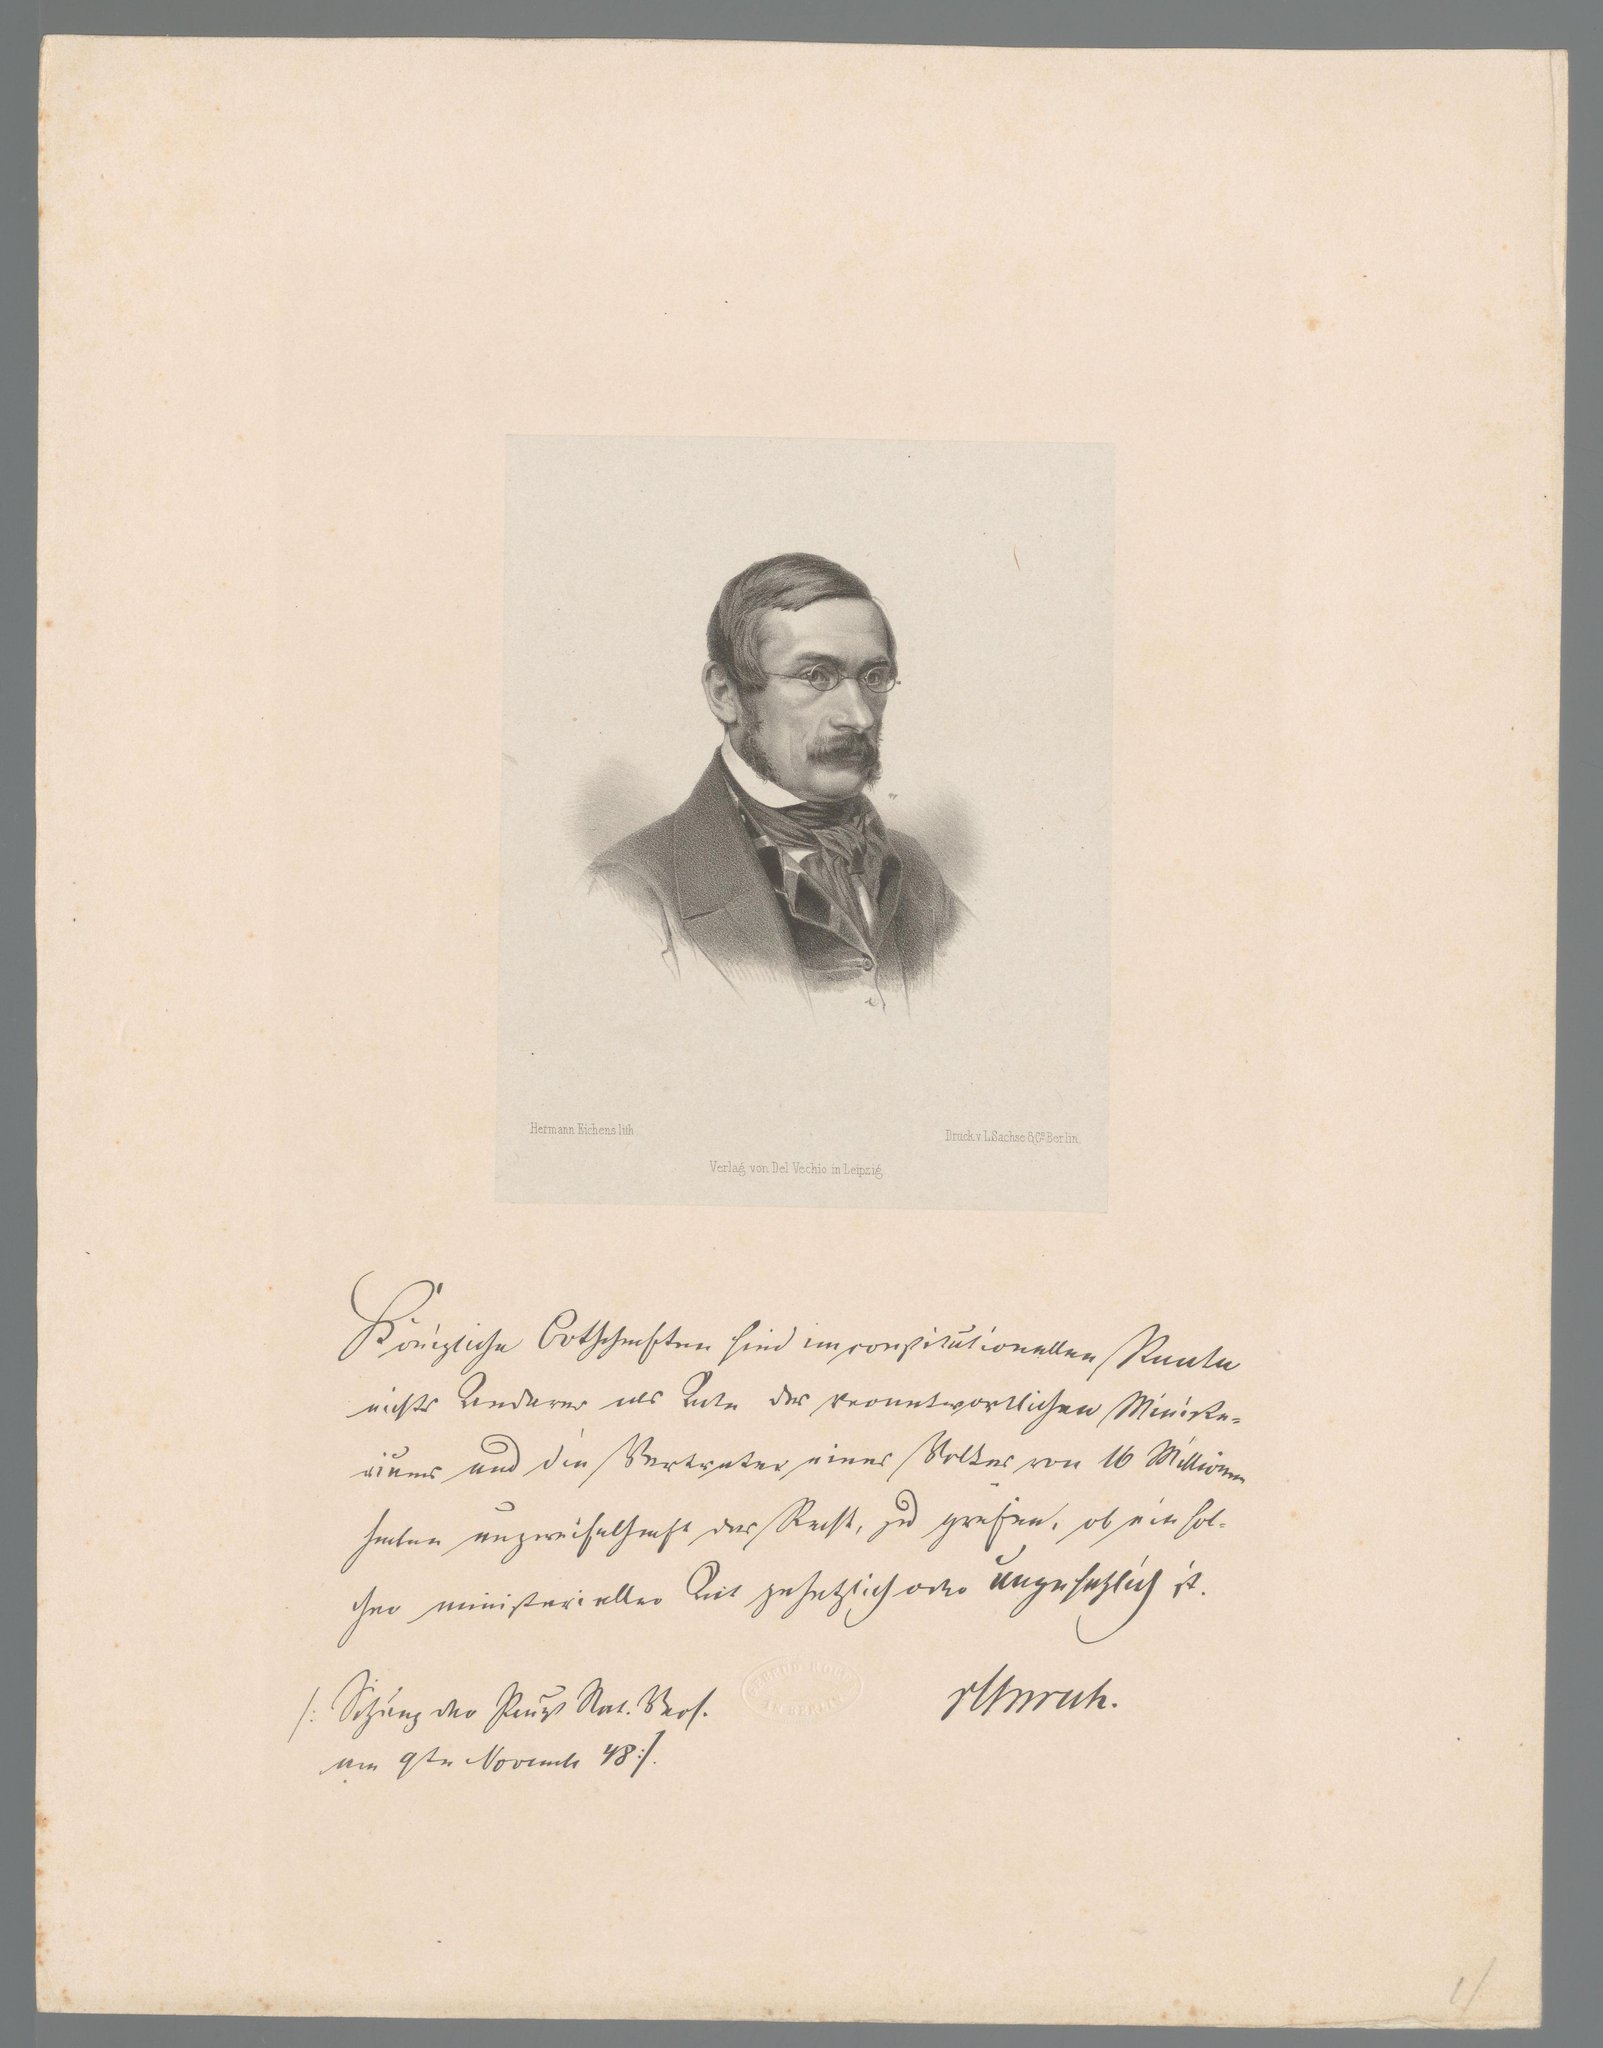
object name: print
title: Portret van een onbekende man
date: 1870-1886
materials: paper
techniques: lithograph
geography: berlin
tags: historical persons not known by name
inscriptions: check stamp: Lugt 2141c, collector's mark: Lugt 2228